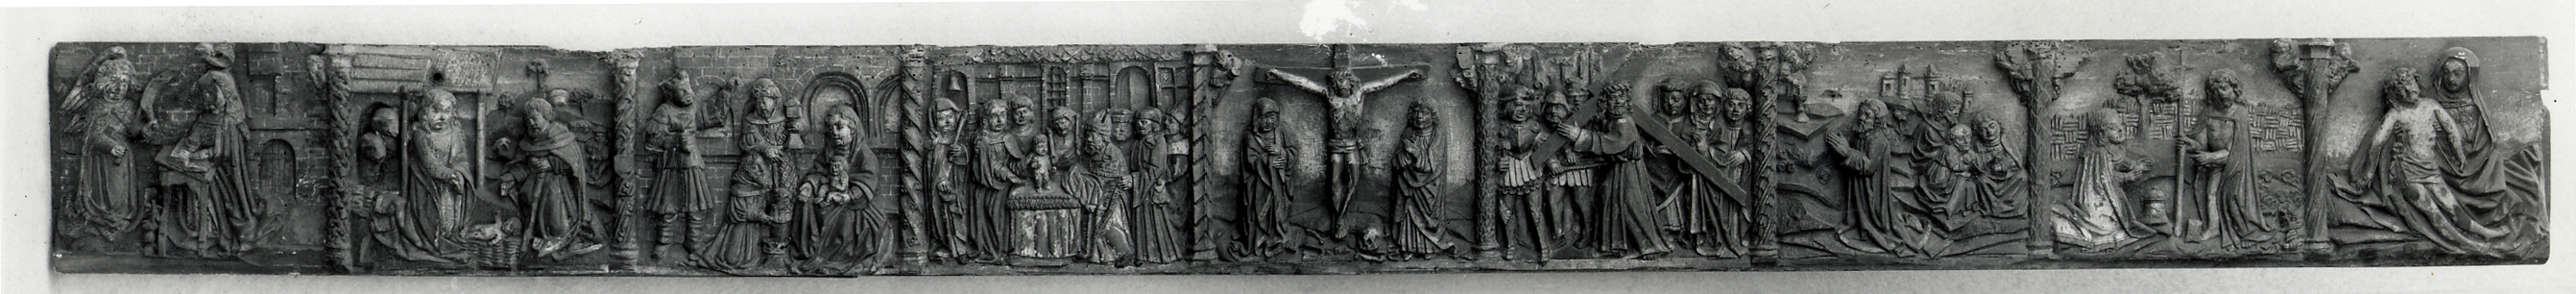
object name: retable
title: Scenes from the Life of Christ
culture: french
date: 1467-1500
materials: wood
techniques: gilding, painting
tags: christ,adoration of the magi,adoration of the shepherds